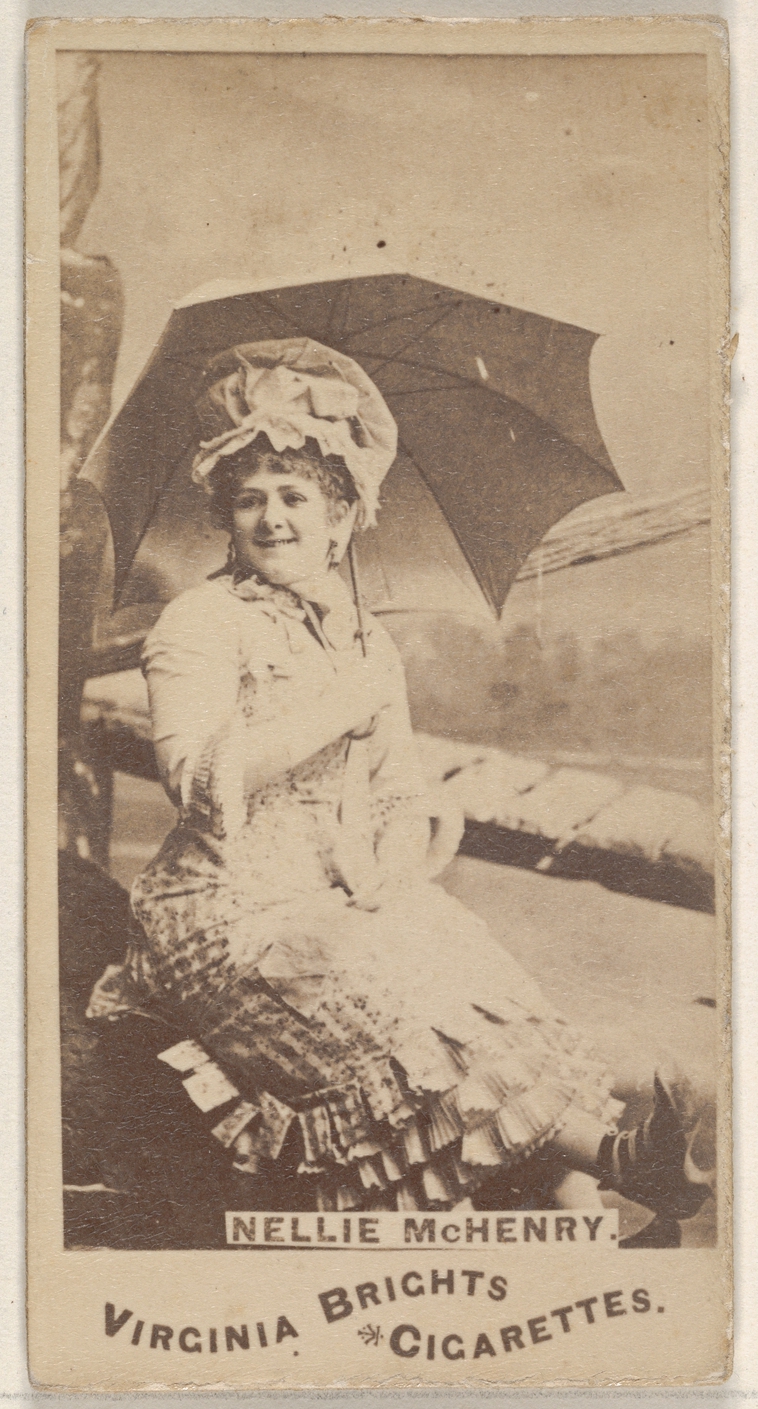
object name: photograph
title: Nellie McHenry, from the Actors and Actresses series (N45, Type 1) for Virginia Brights Cigarettes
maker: allen & ginter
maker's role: publisher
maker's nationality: american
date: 1888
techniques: albumen silver print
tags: portraits,women,actresses